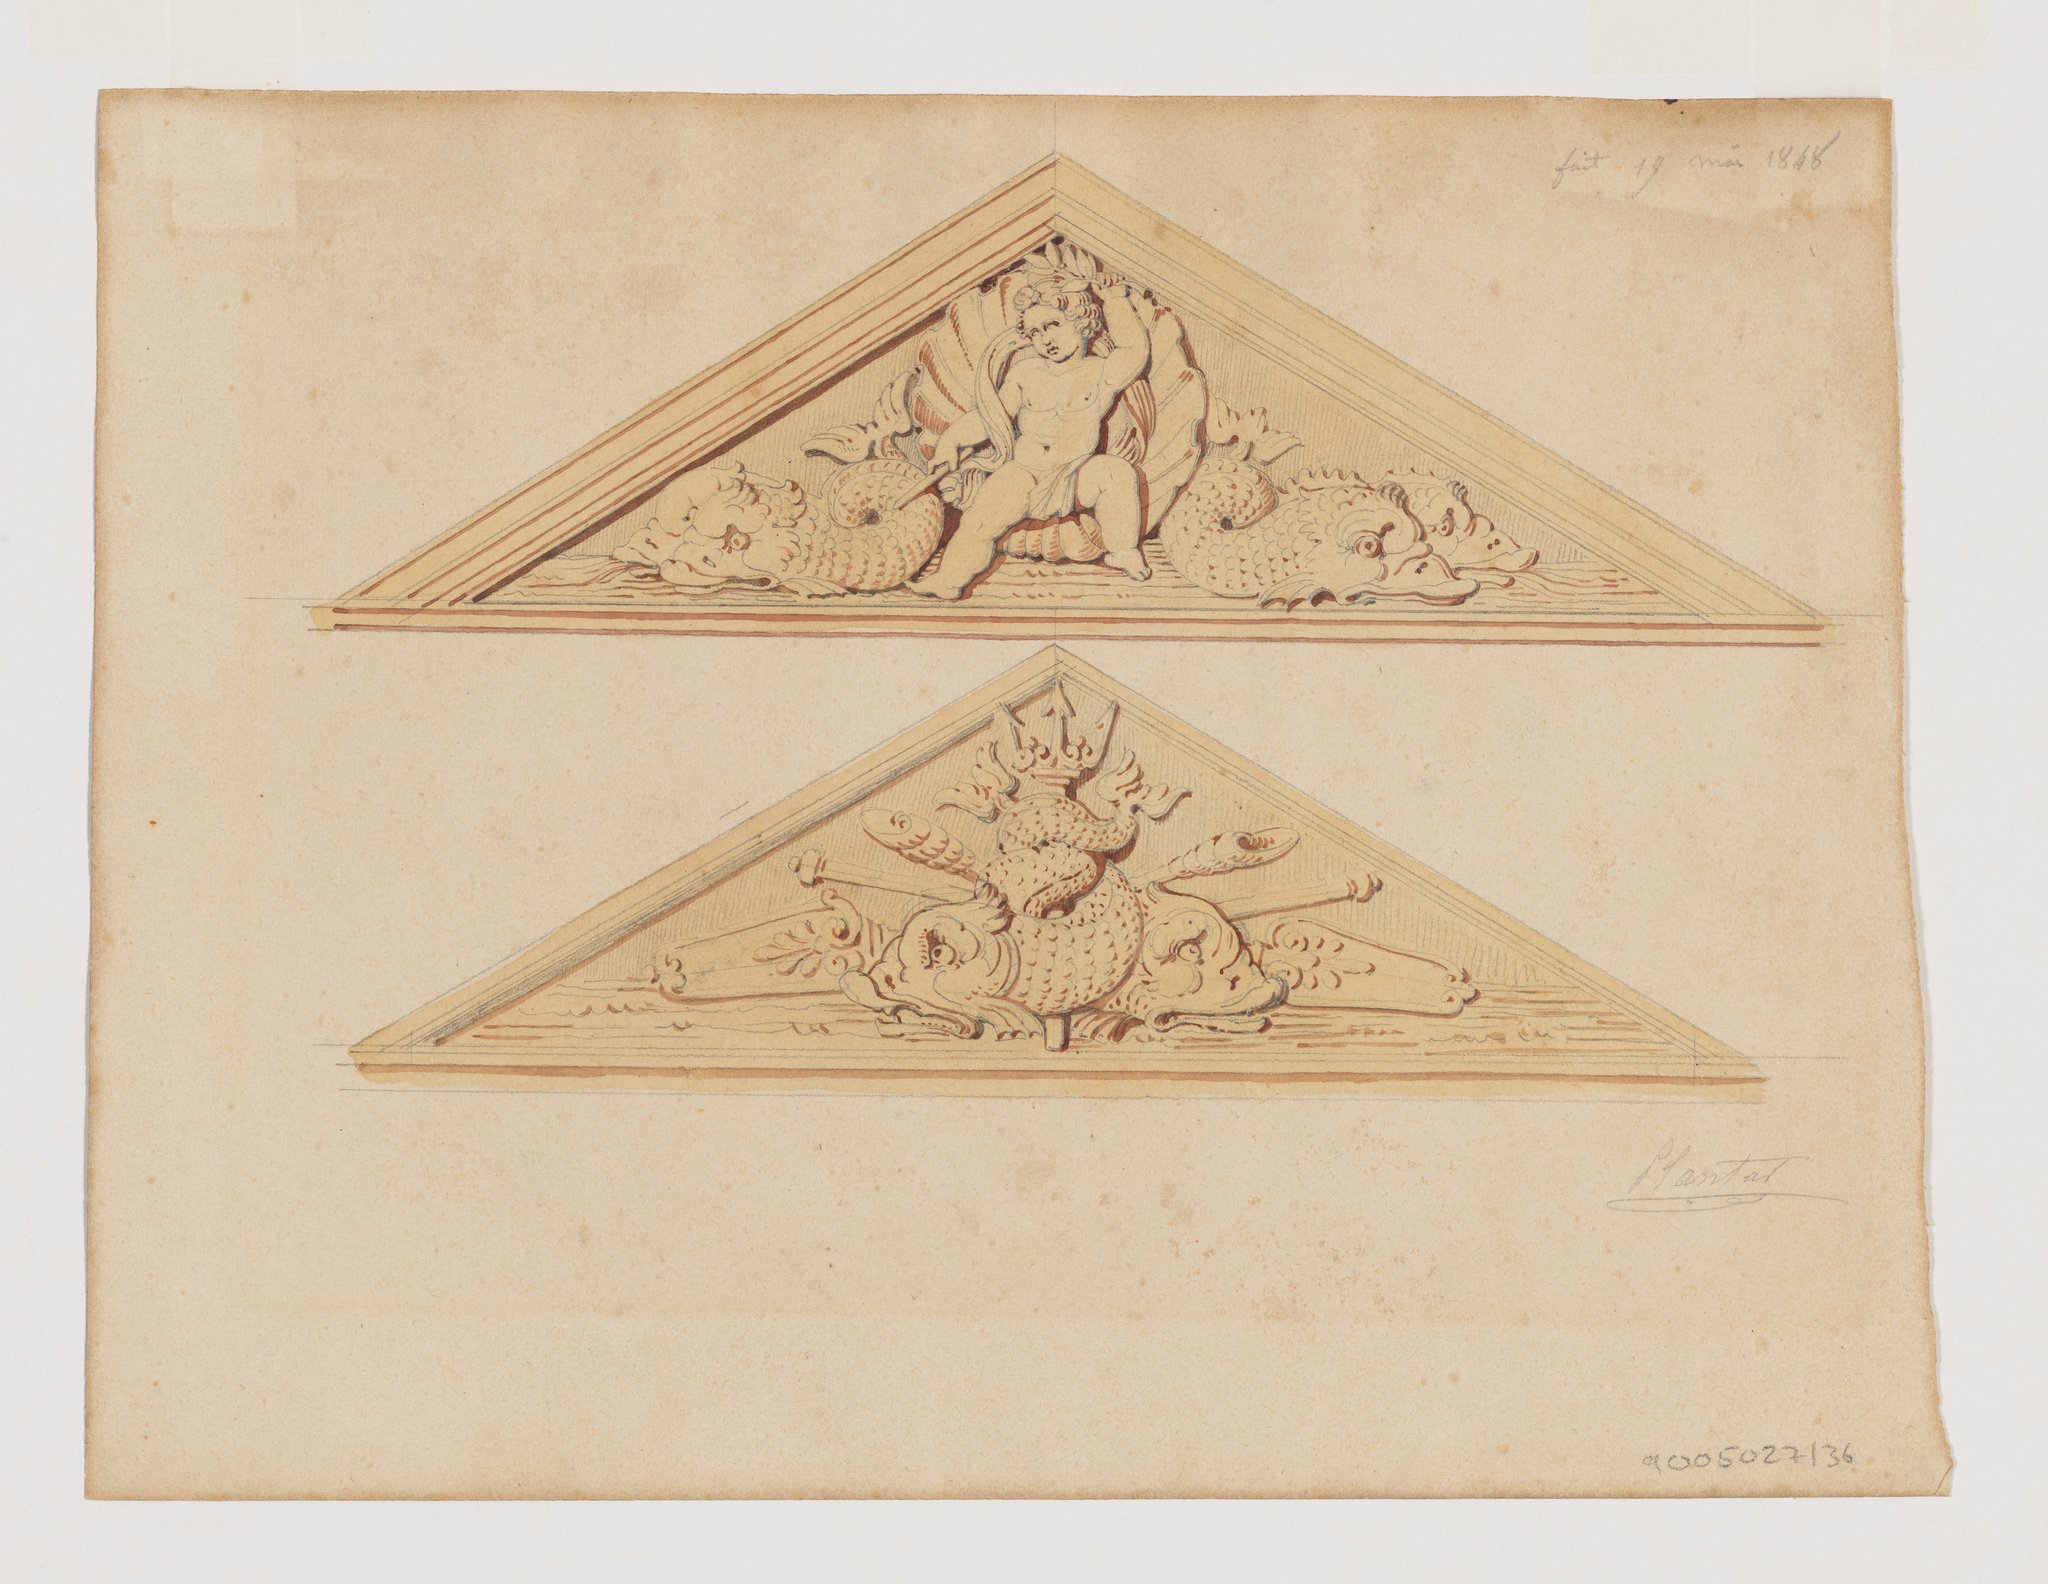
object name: drawing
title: Two Designs for Pediments with Putti and Sea Creatures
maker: jean-baptiste louis plantar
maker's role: artist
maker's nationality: french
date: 1834-1866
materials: graphite, ink, watercolor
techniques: pen